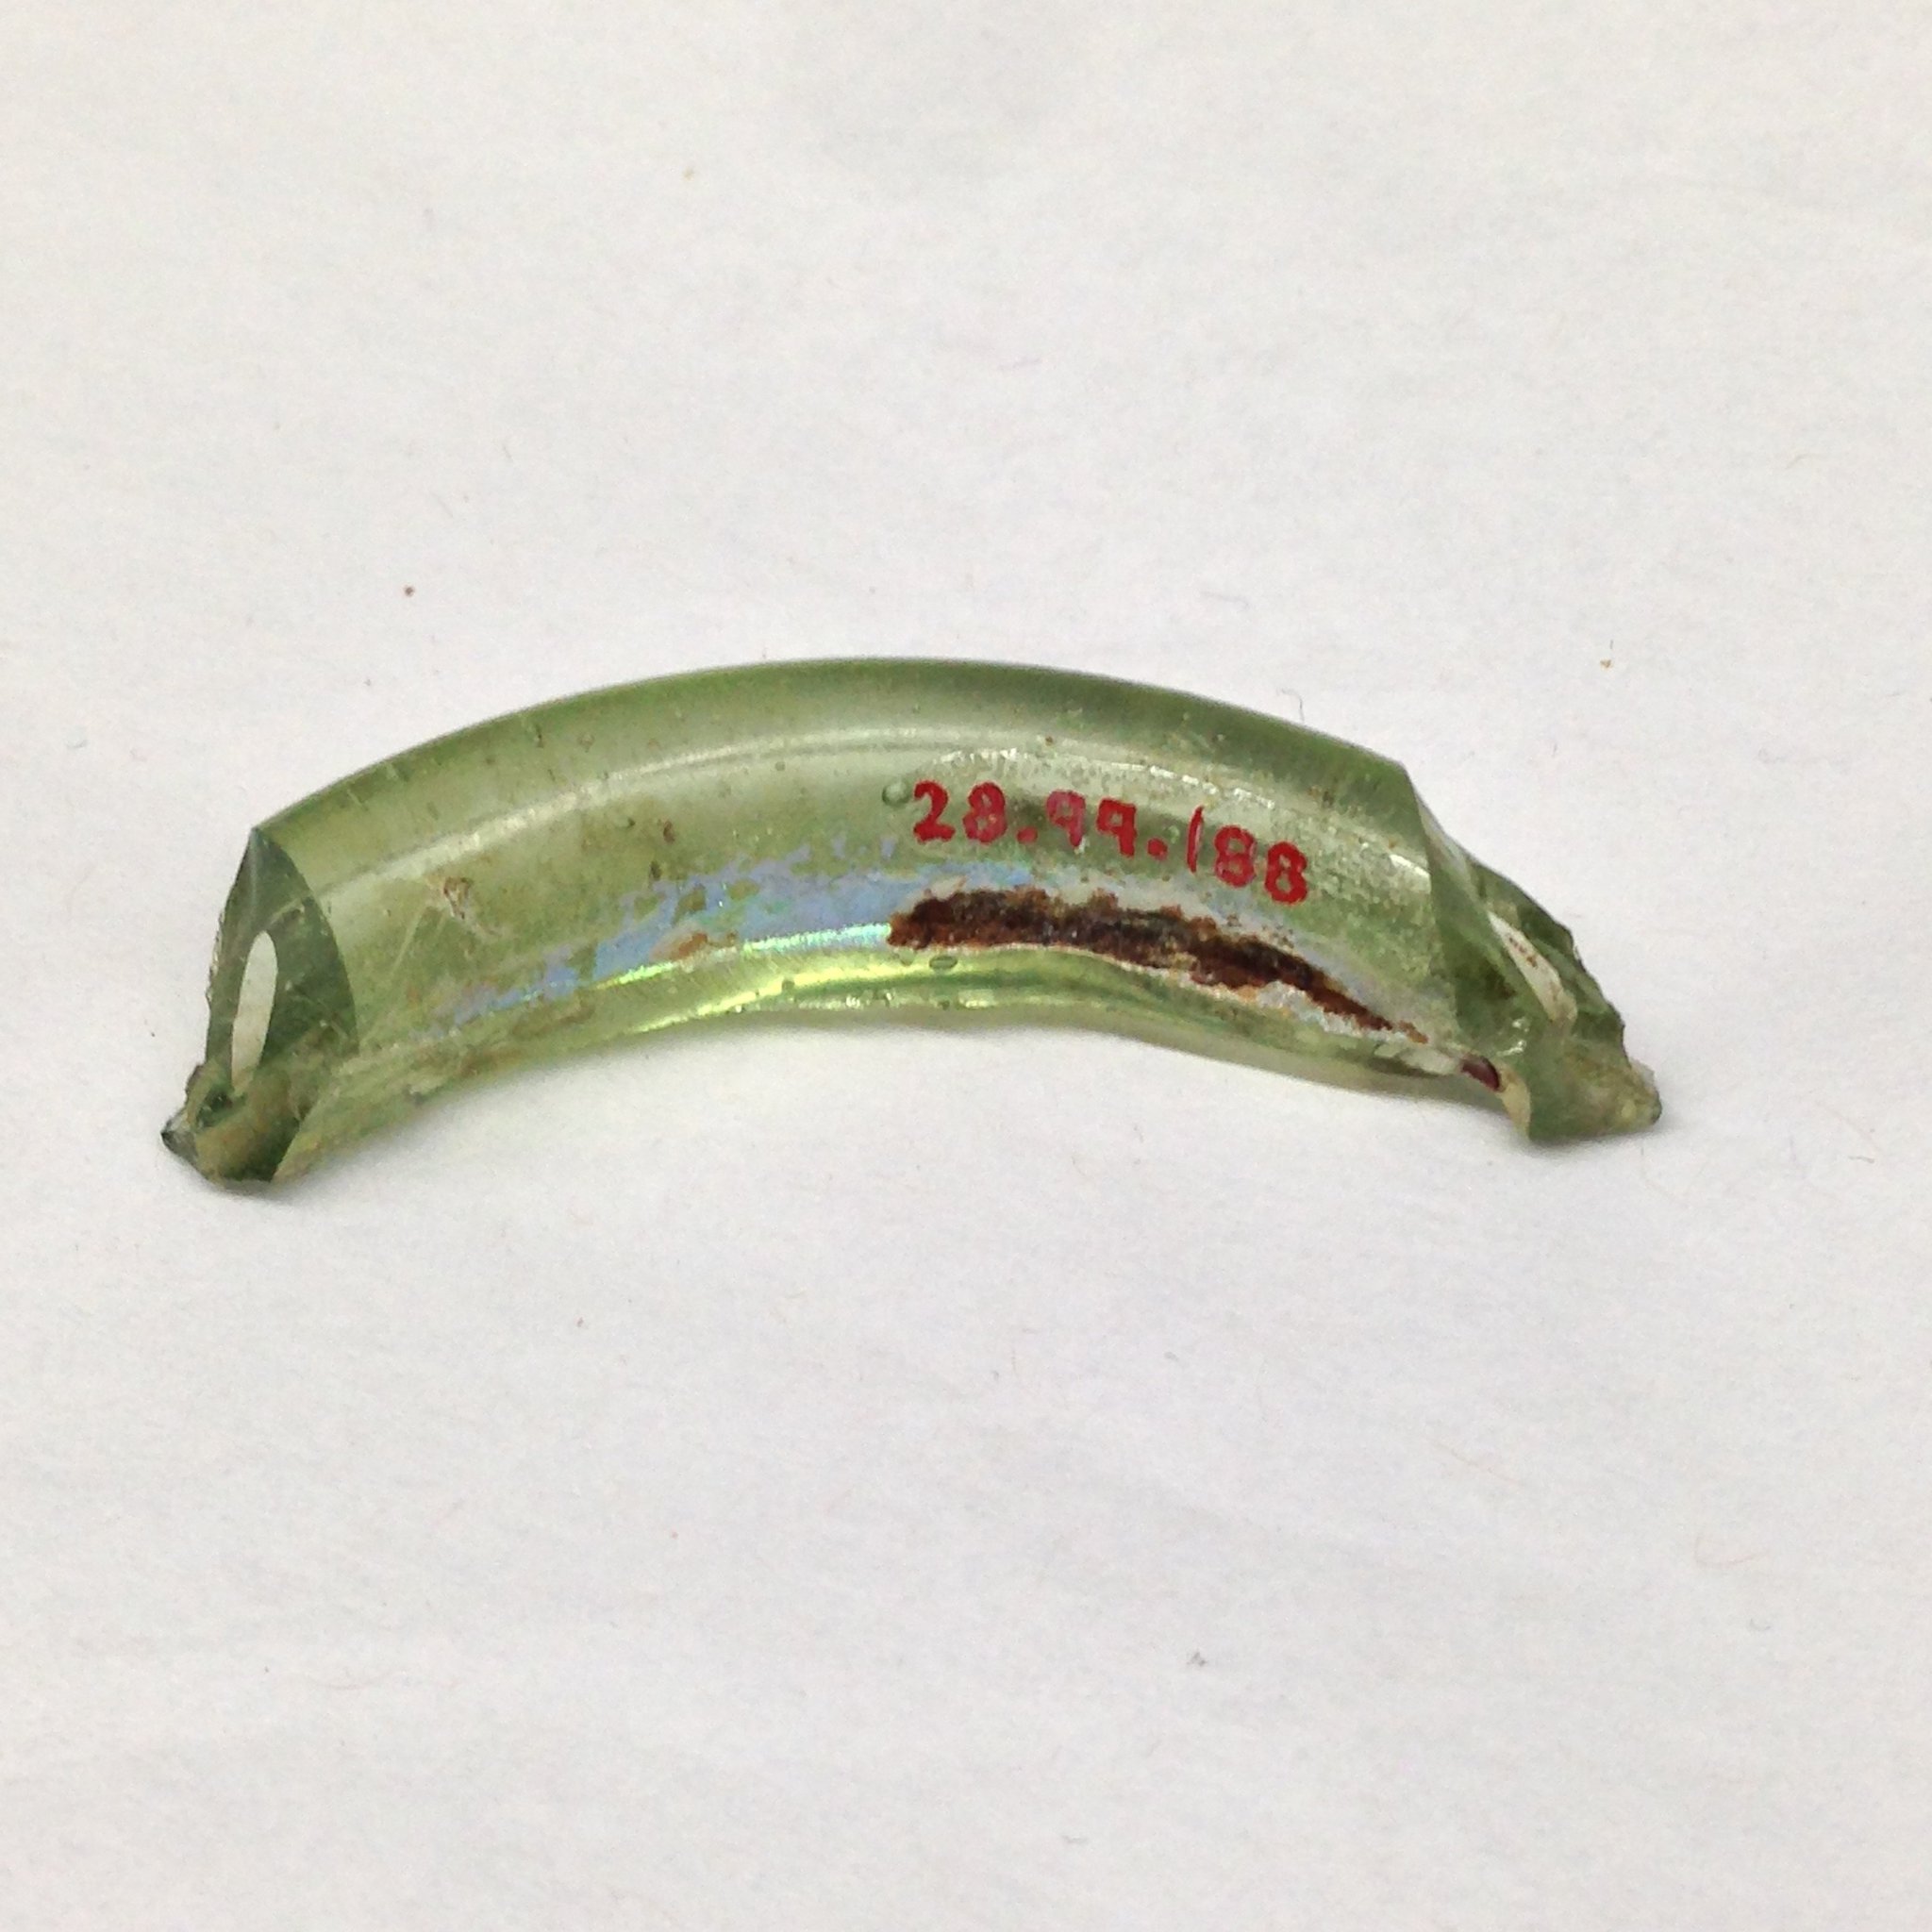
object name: fragment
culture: european or middle eastern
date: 1150-1250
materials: ceramic, glass